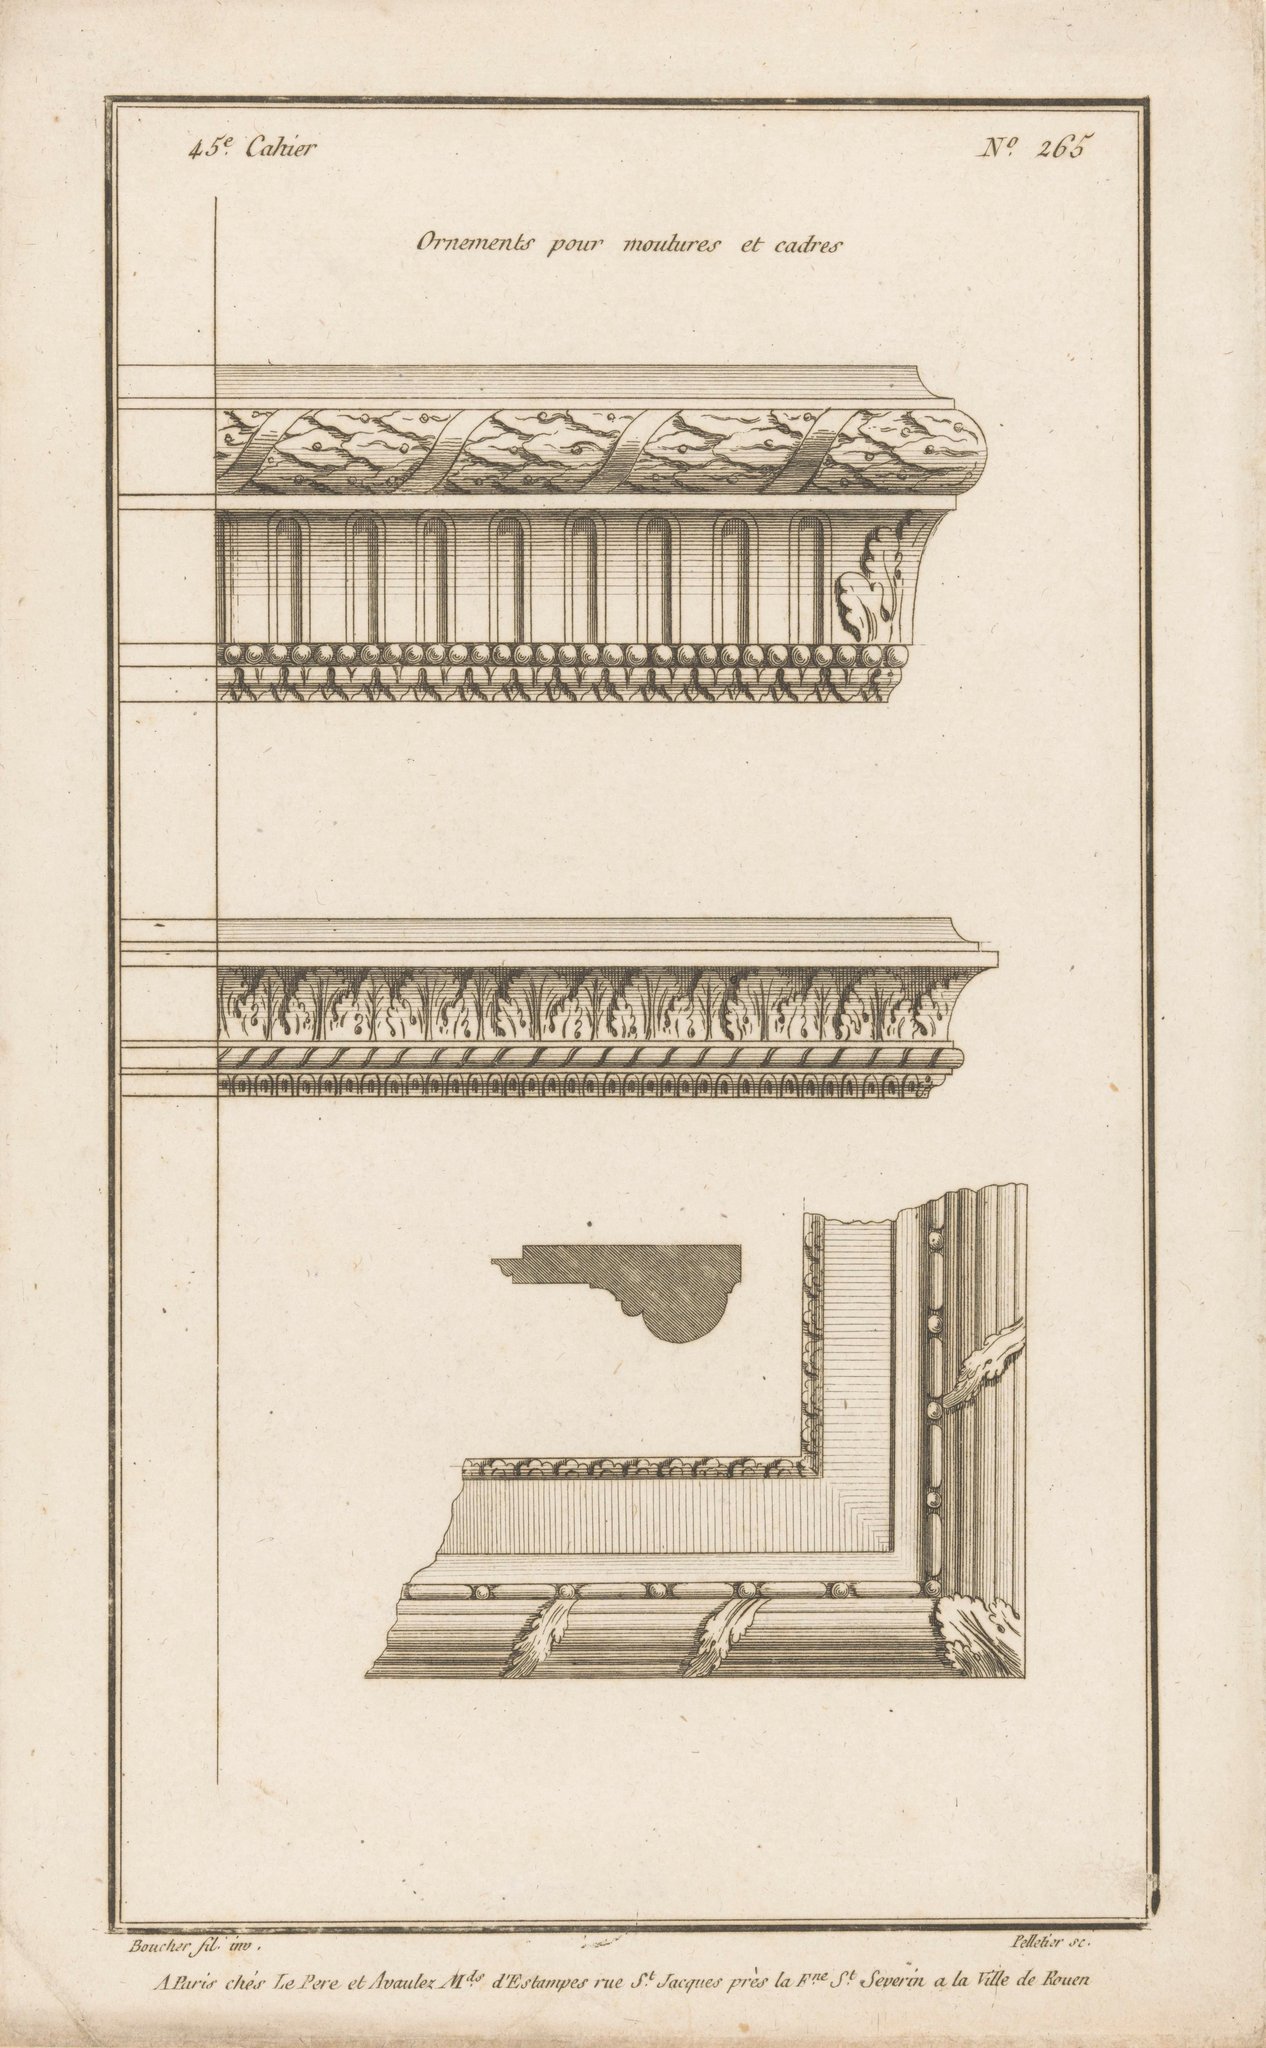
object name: print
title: Lijsten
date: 1772-1779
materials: paper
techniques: engraving, etching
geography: paris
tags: other architectural details (cornice), foliage ~ ornament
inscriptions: collector's mark: Lugt 2228, collector's mark: Lugt 2760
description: Twee geornamenteerde lijsten met bladmotieven en een hoekornament met profiel. Prentnummer 265.